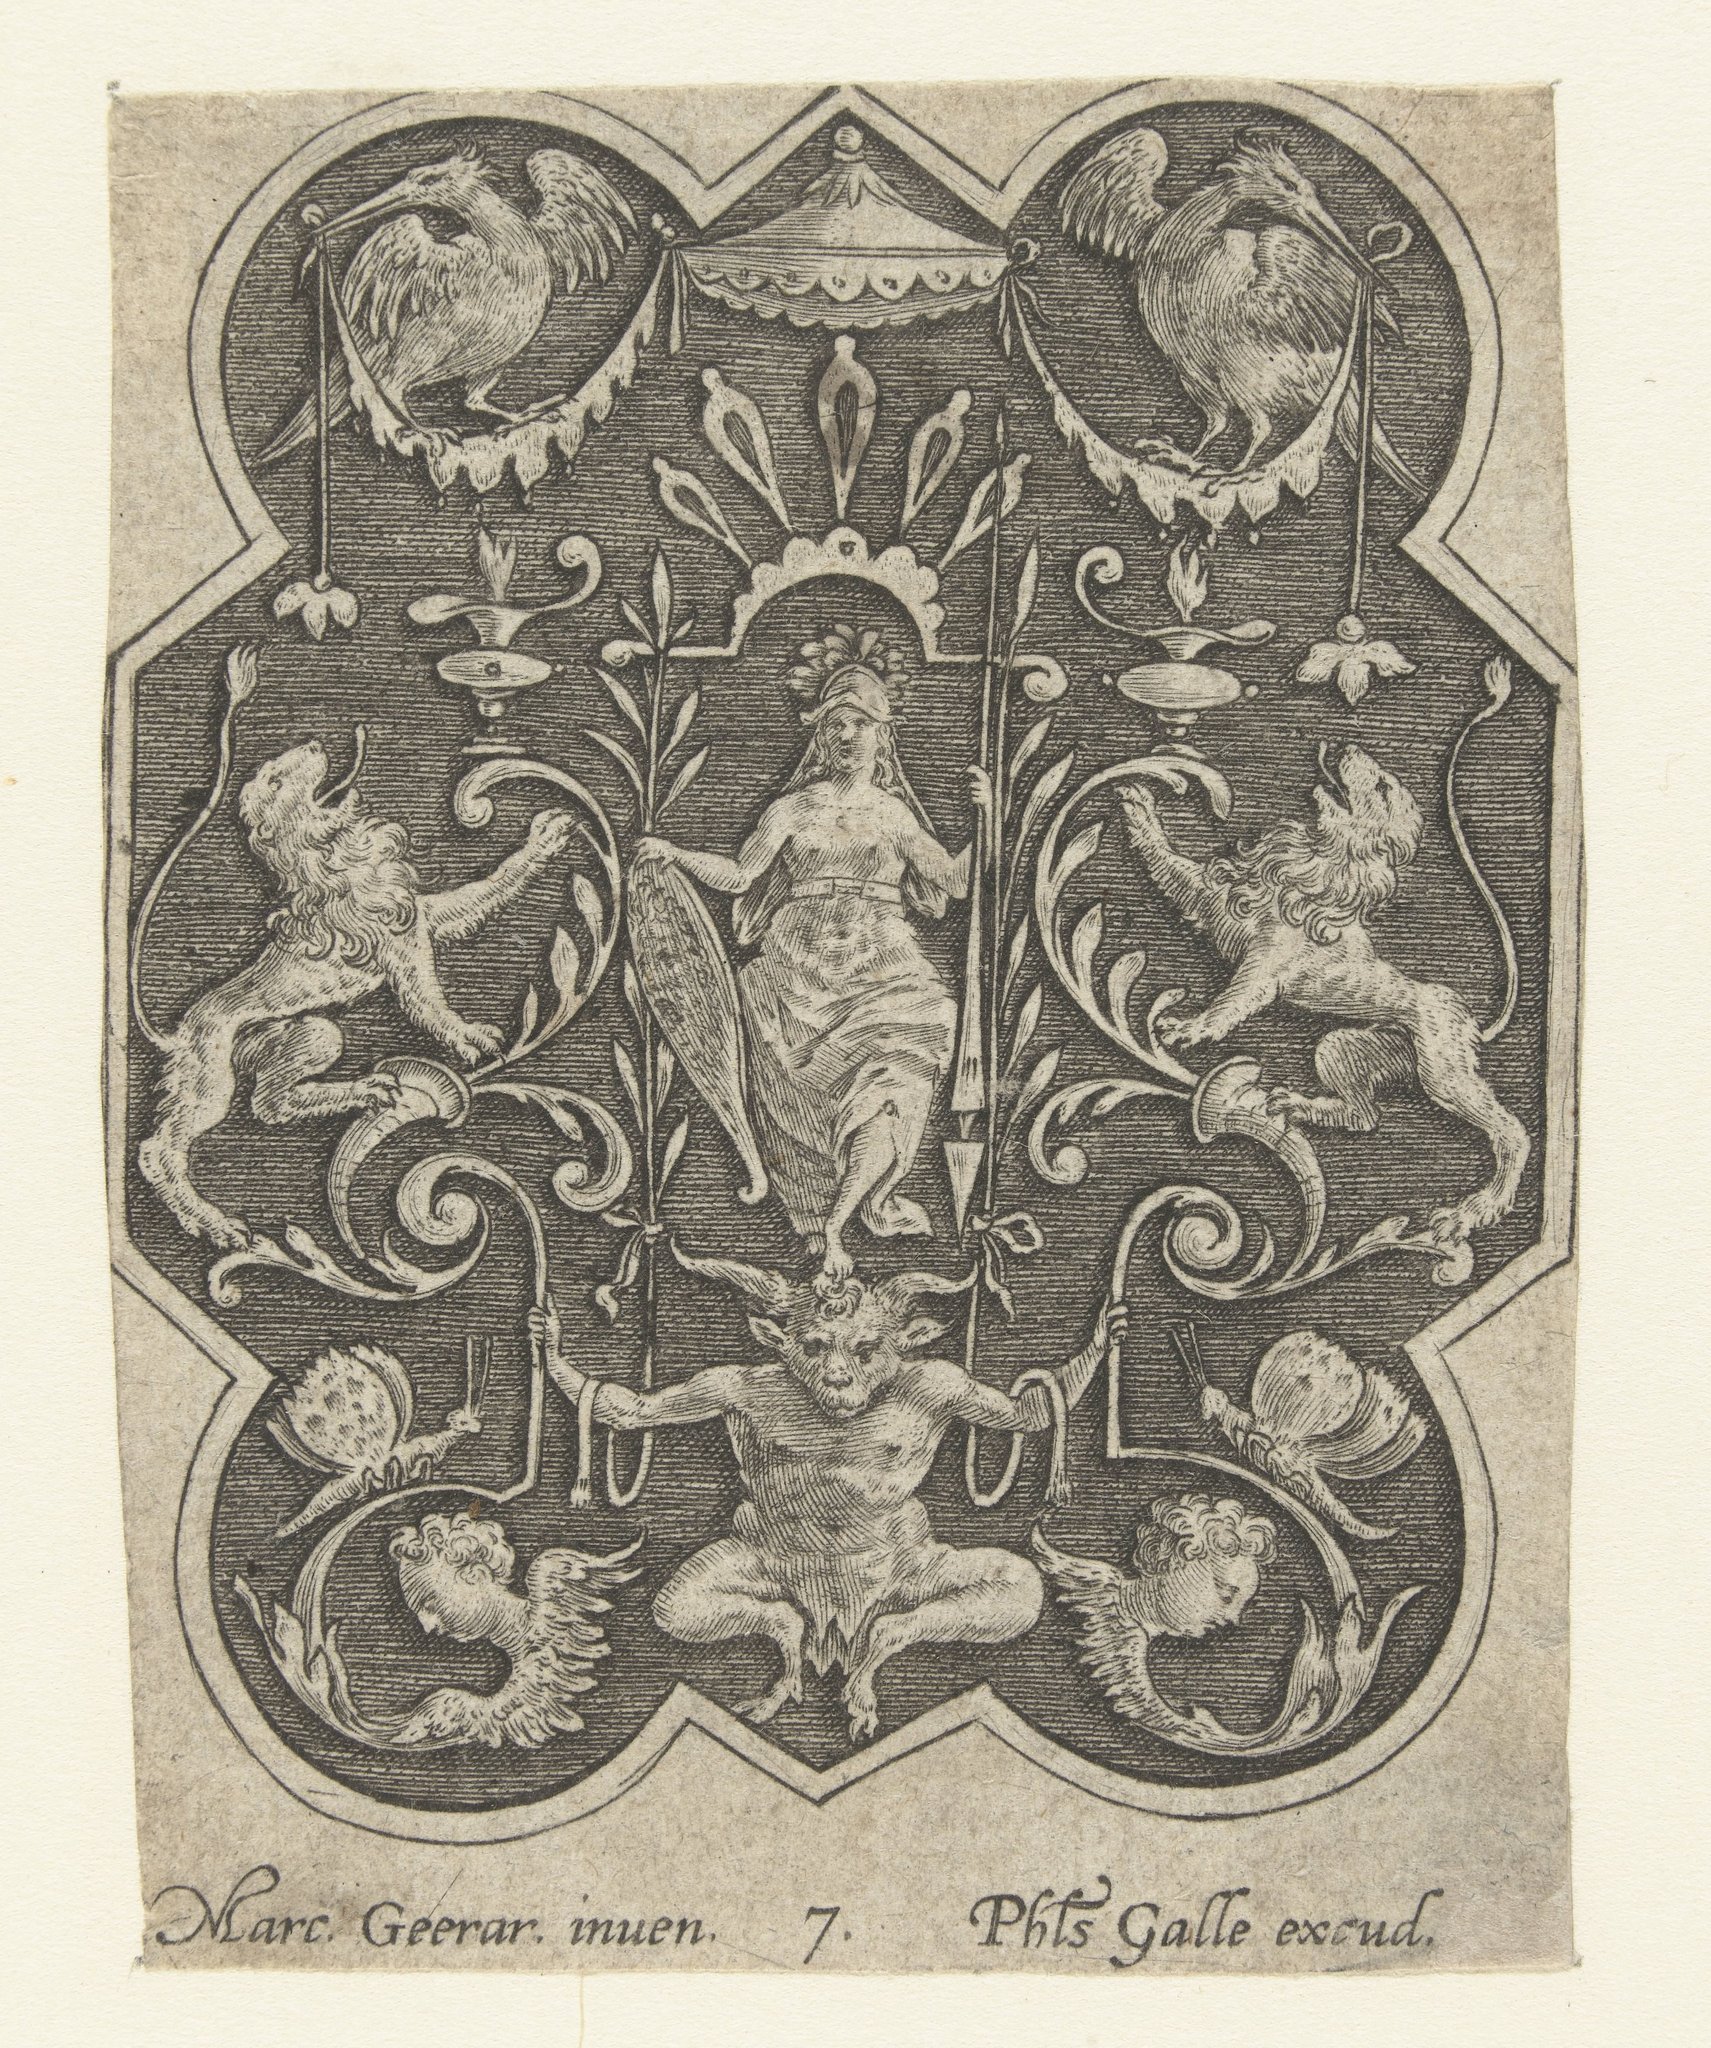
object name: ornament print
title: Ornamenten. N( 3, 5, 6, 7 uit de suite van 12 stuks. Phls. Gallerus excud.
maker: philips galle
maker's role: print maker, publisher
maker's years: 1537-1612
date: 1547-1612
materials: paper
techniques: engraving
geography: netherlands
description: Ruit met afgeplatte zijkanten en uitstulpingen in de vorm van cirkels, in het midden staat een vrouw op het hoofd van een sater. Blad 7 van 5 genummerde bladen uit een serie van 12.